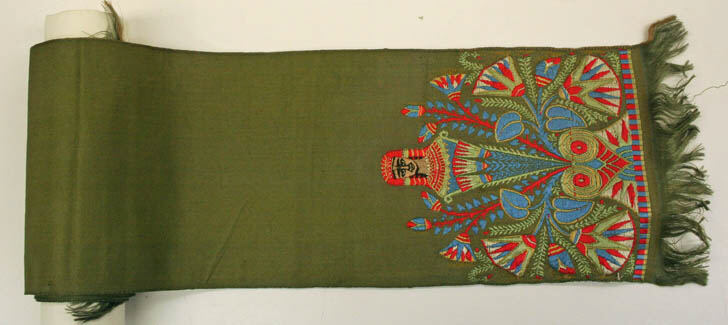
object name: sash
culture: european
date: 1826-1850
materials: silk